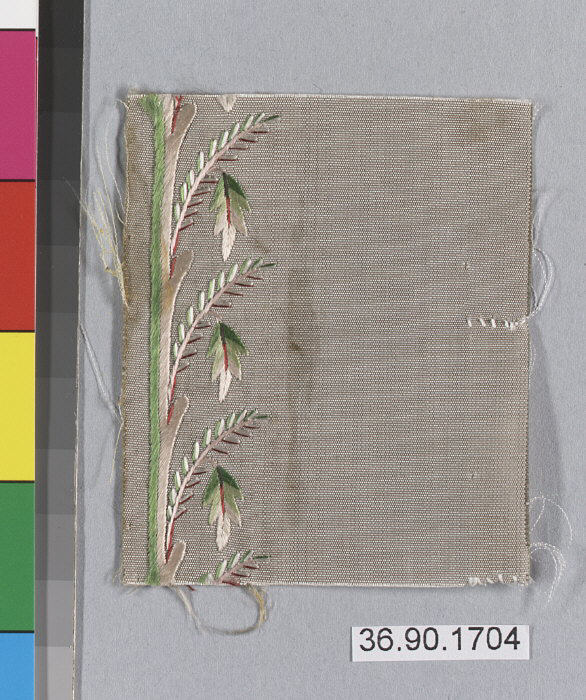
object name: sample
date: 1801-1833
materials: silk